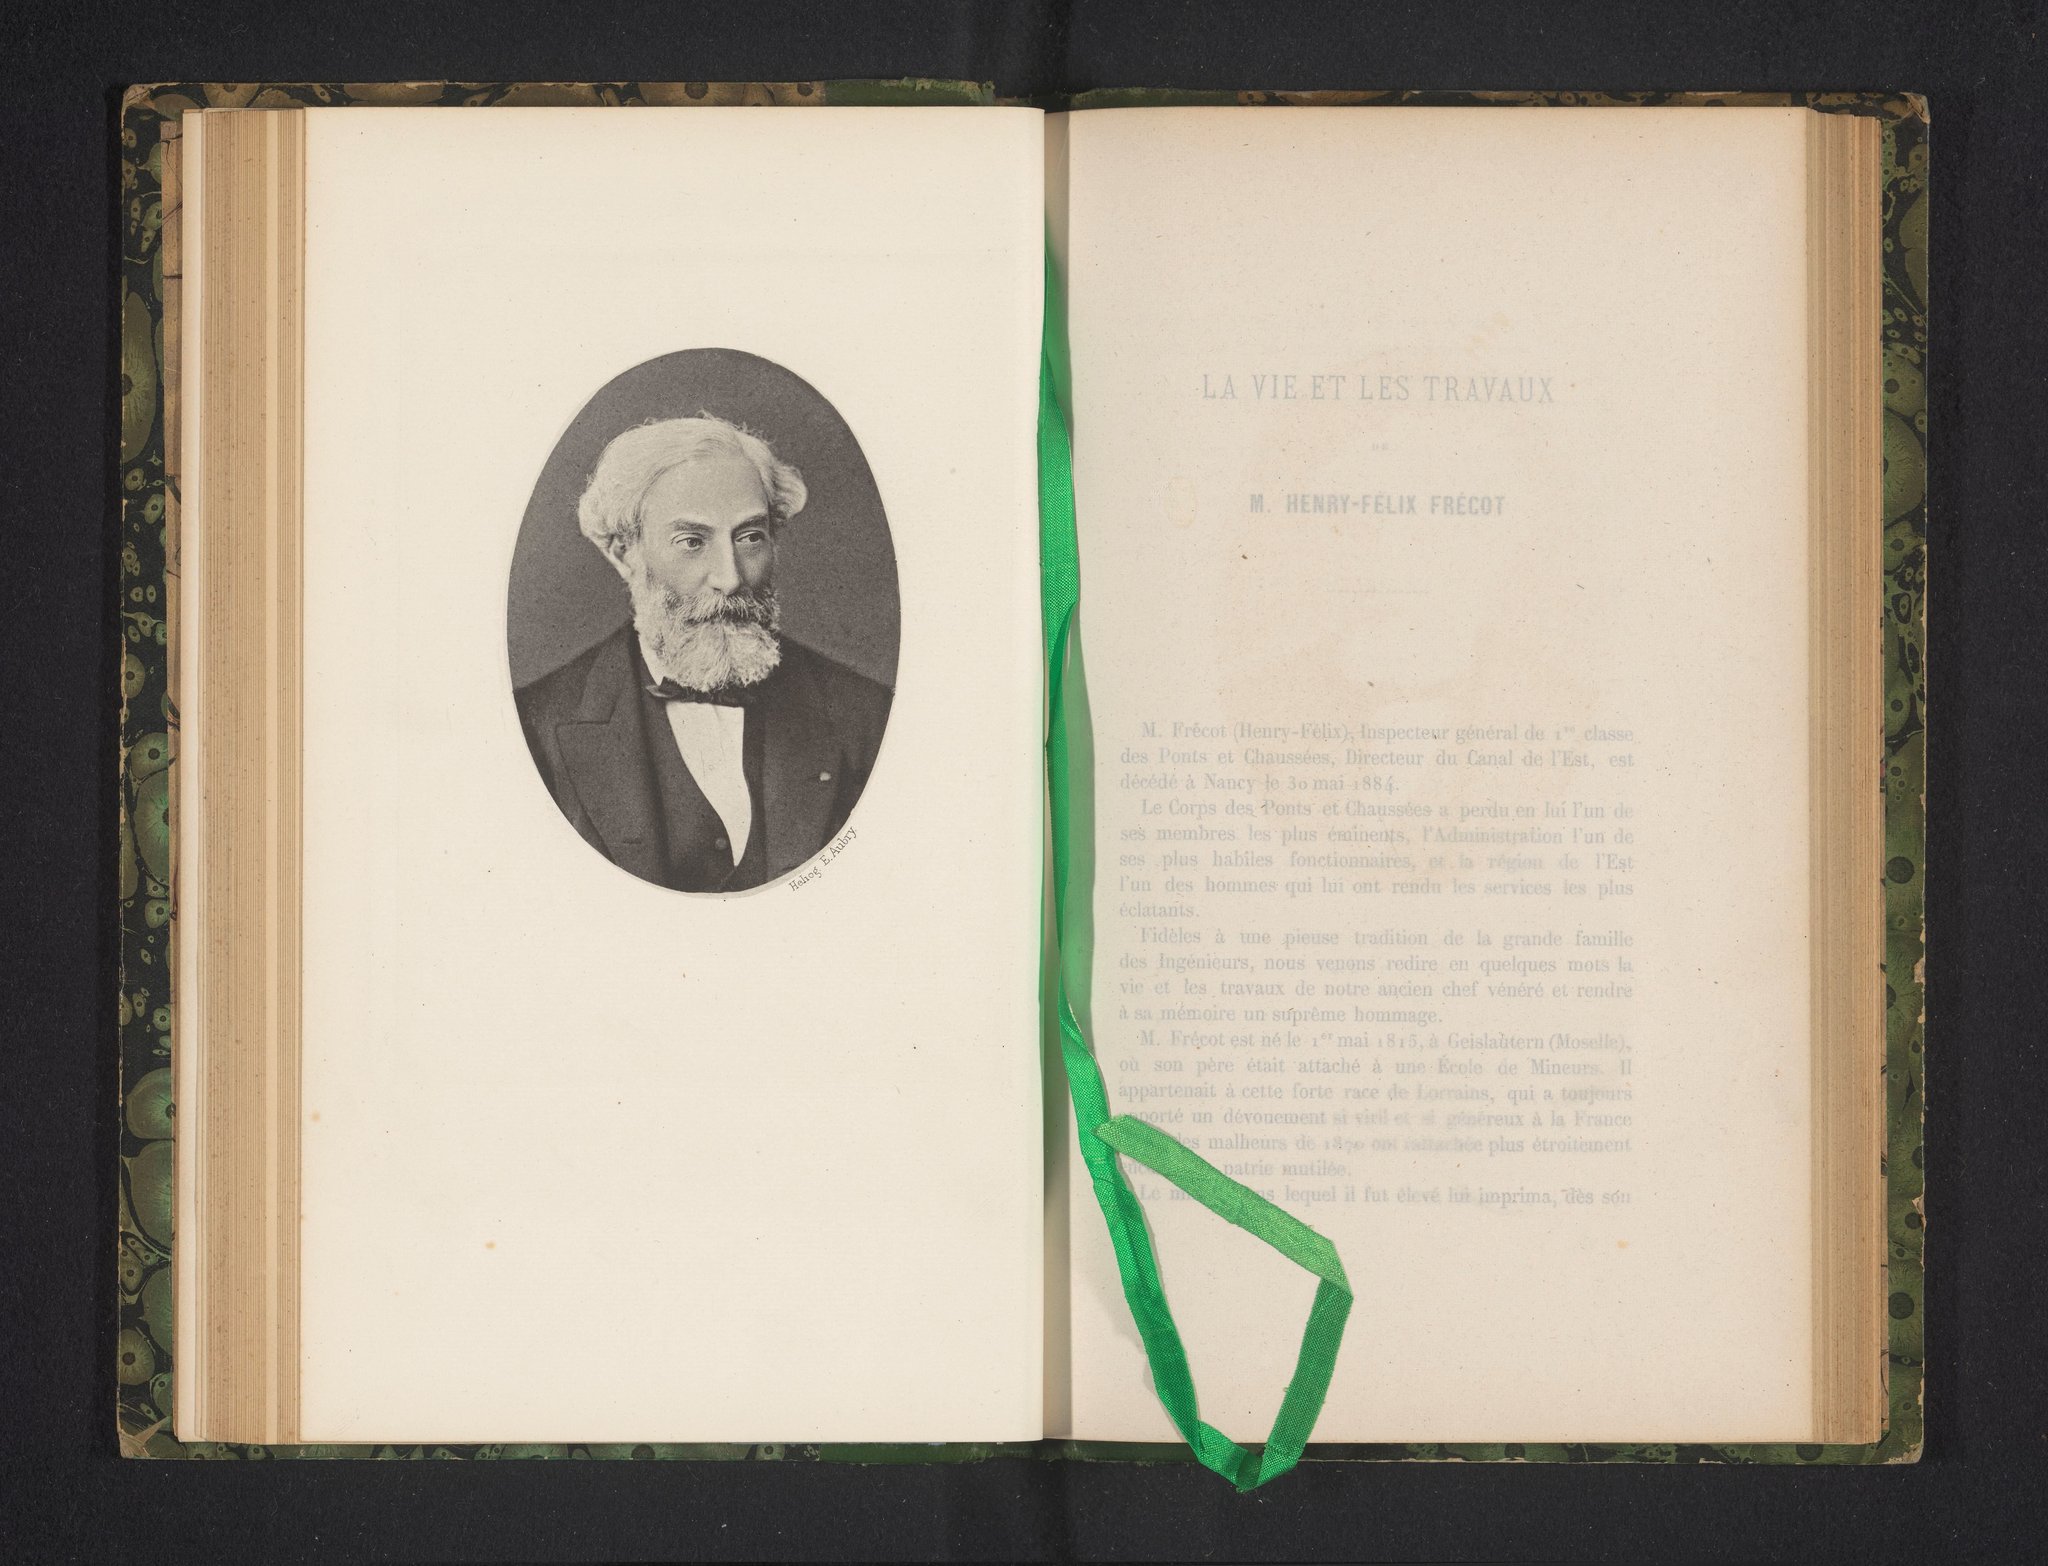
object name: page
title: Portret van Henry-Félix Frécot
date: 1879-1884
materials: paper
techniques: photograph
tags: historical persons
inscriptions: inscription: ‘heliog. E. Aubry’